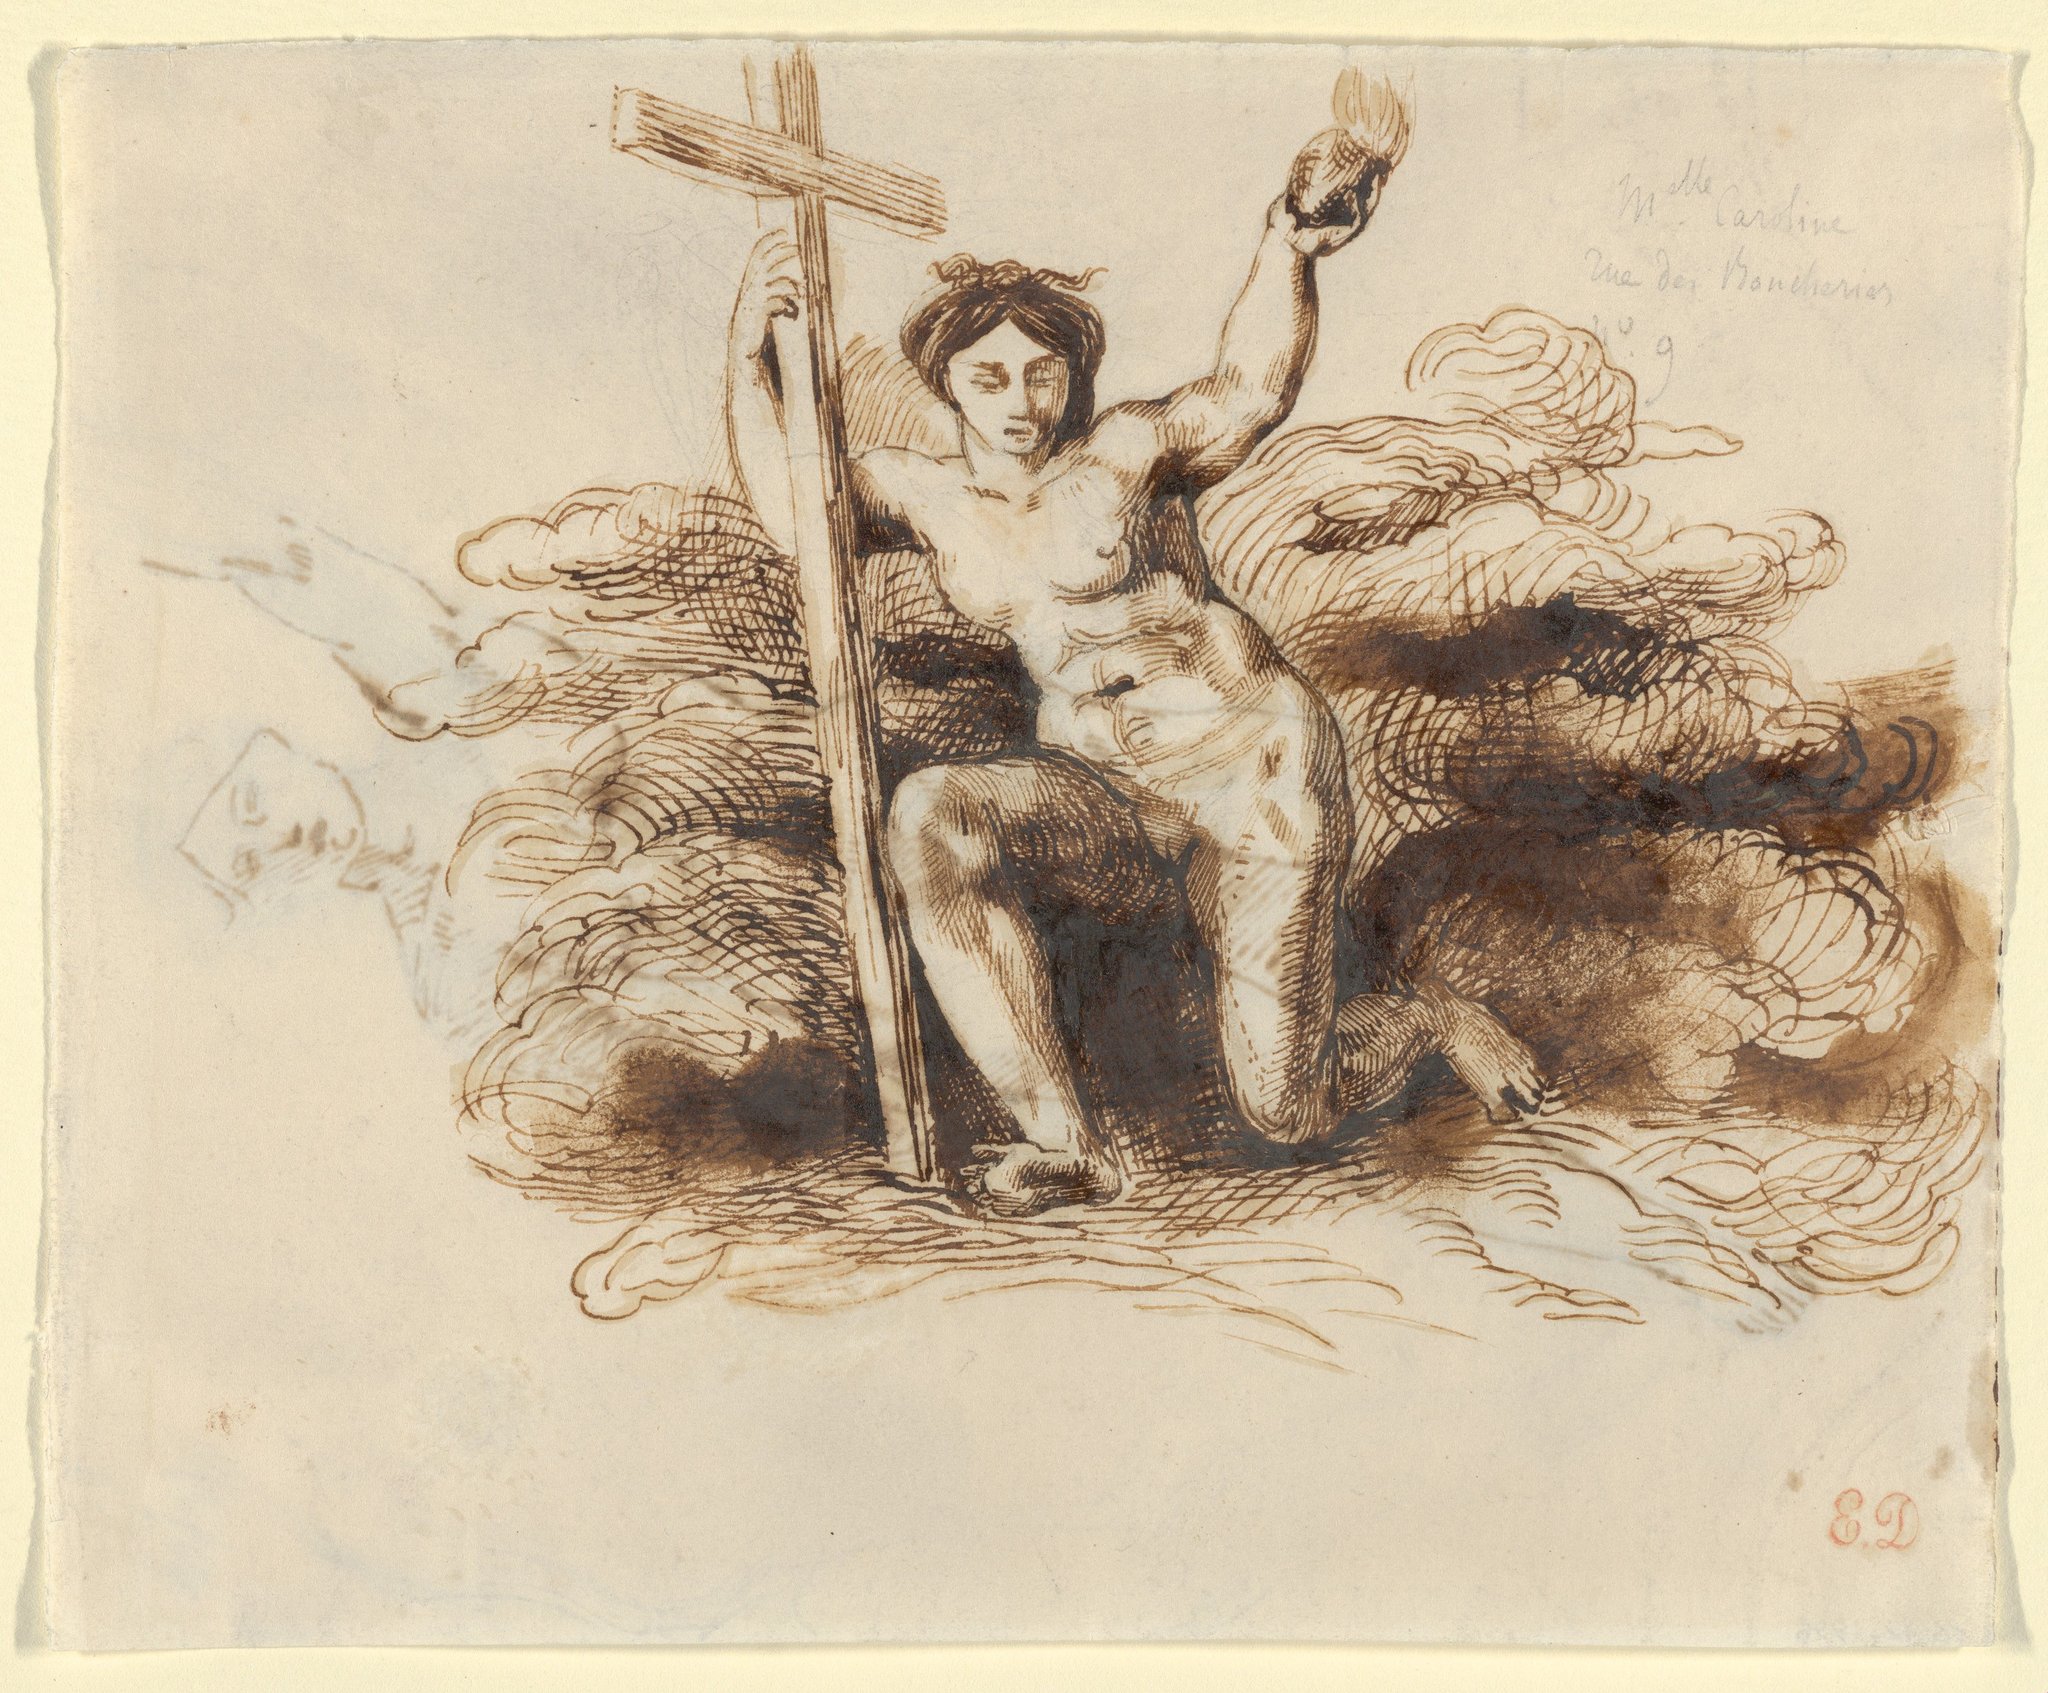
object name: drawing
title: The Figure of Religion (recto/verso)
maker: eugène delacroix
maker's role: artist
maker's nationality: french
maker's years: 1798-1863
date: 1820-1821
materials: graphite, ink, iron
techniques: brush, pen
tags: female nudes,cross